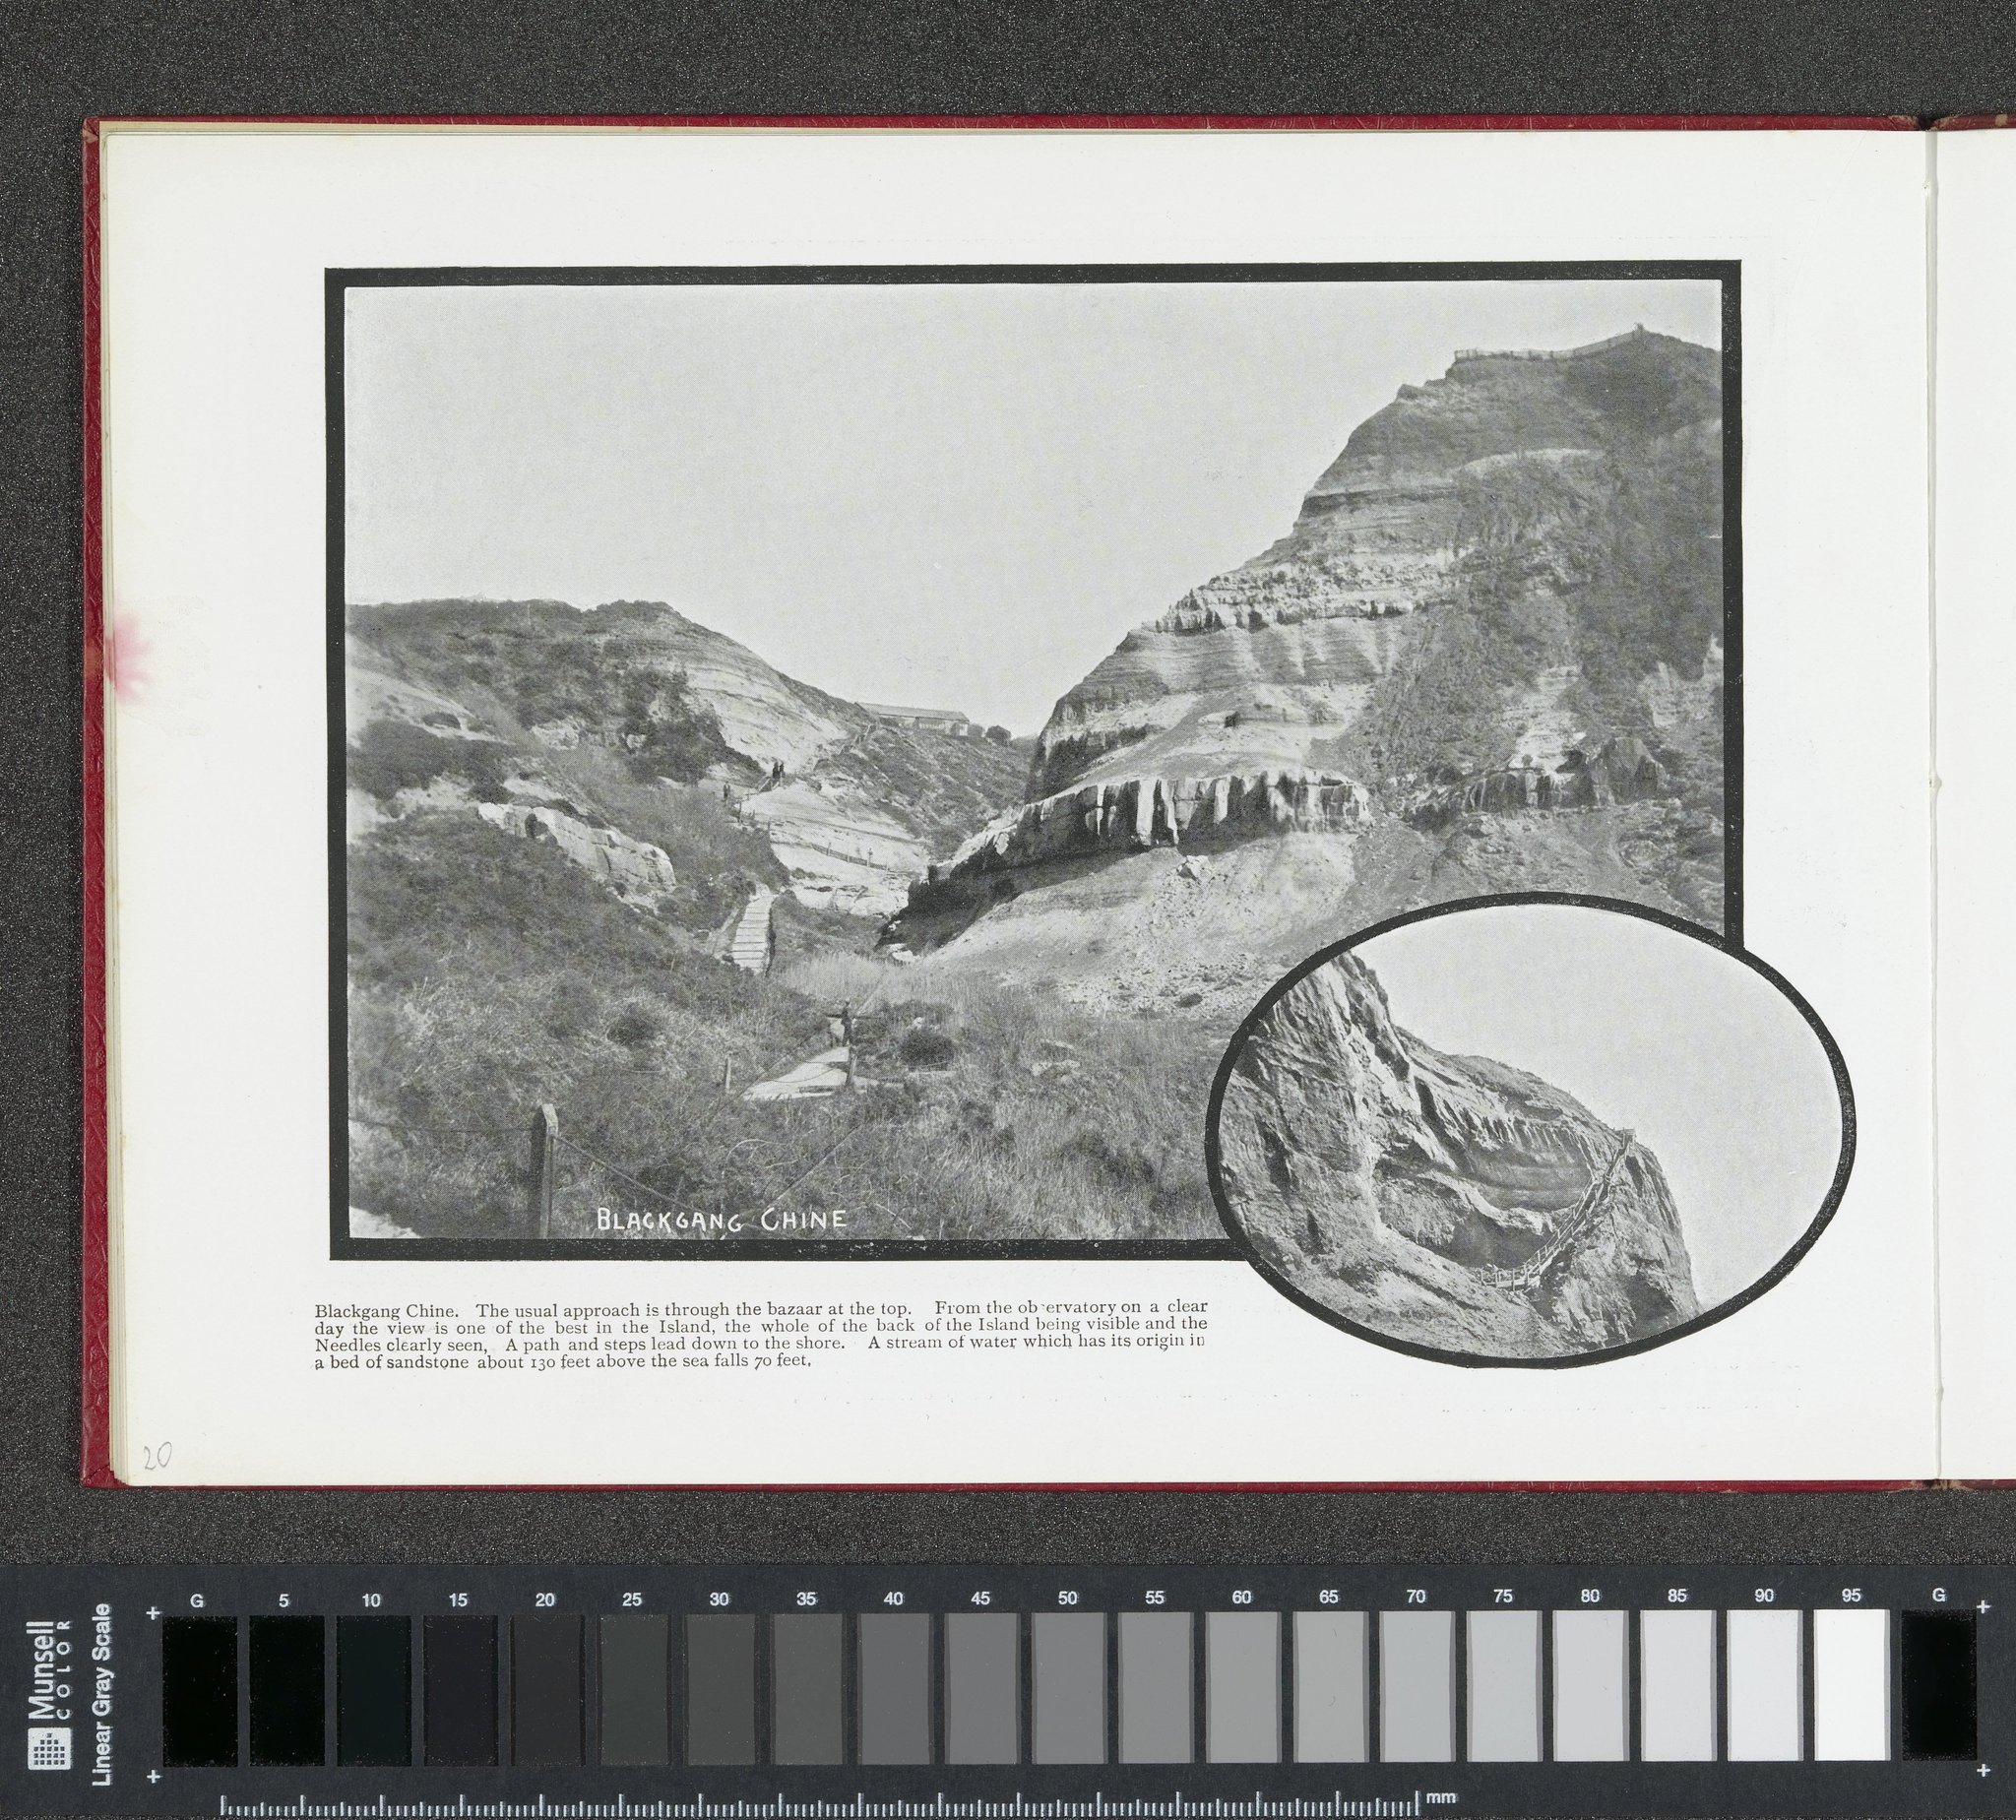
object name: photograph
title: Blackgang Chine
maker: Anonymous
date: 1897-1930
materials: paper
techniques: printing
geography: isle of wight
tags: inland cliff face (+ landscape with figures, staffage), ravine, chasm, abyss, canyon, travelling; tourism, isle of wight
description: Pagina 20 met 2 foto's van Blackgang Chine en een bijschrift. Onderdeel van Fotografische reisreportage van het eiland Wight.